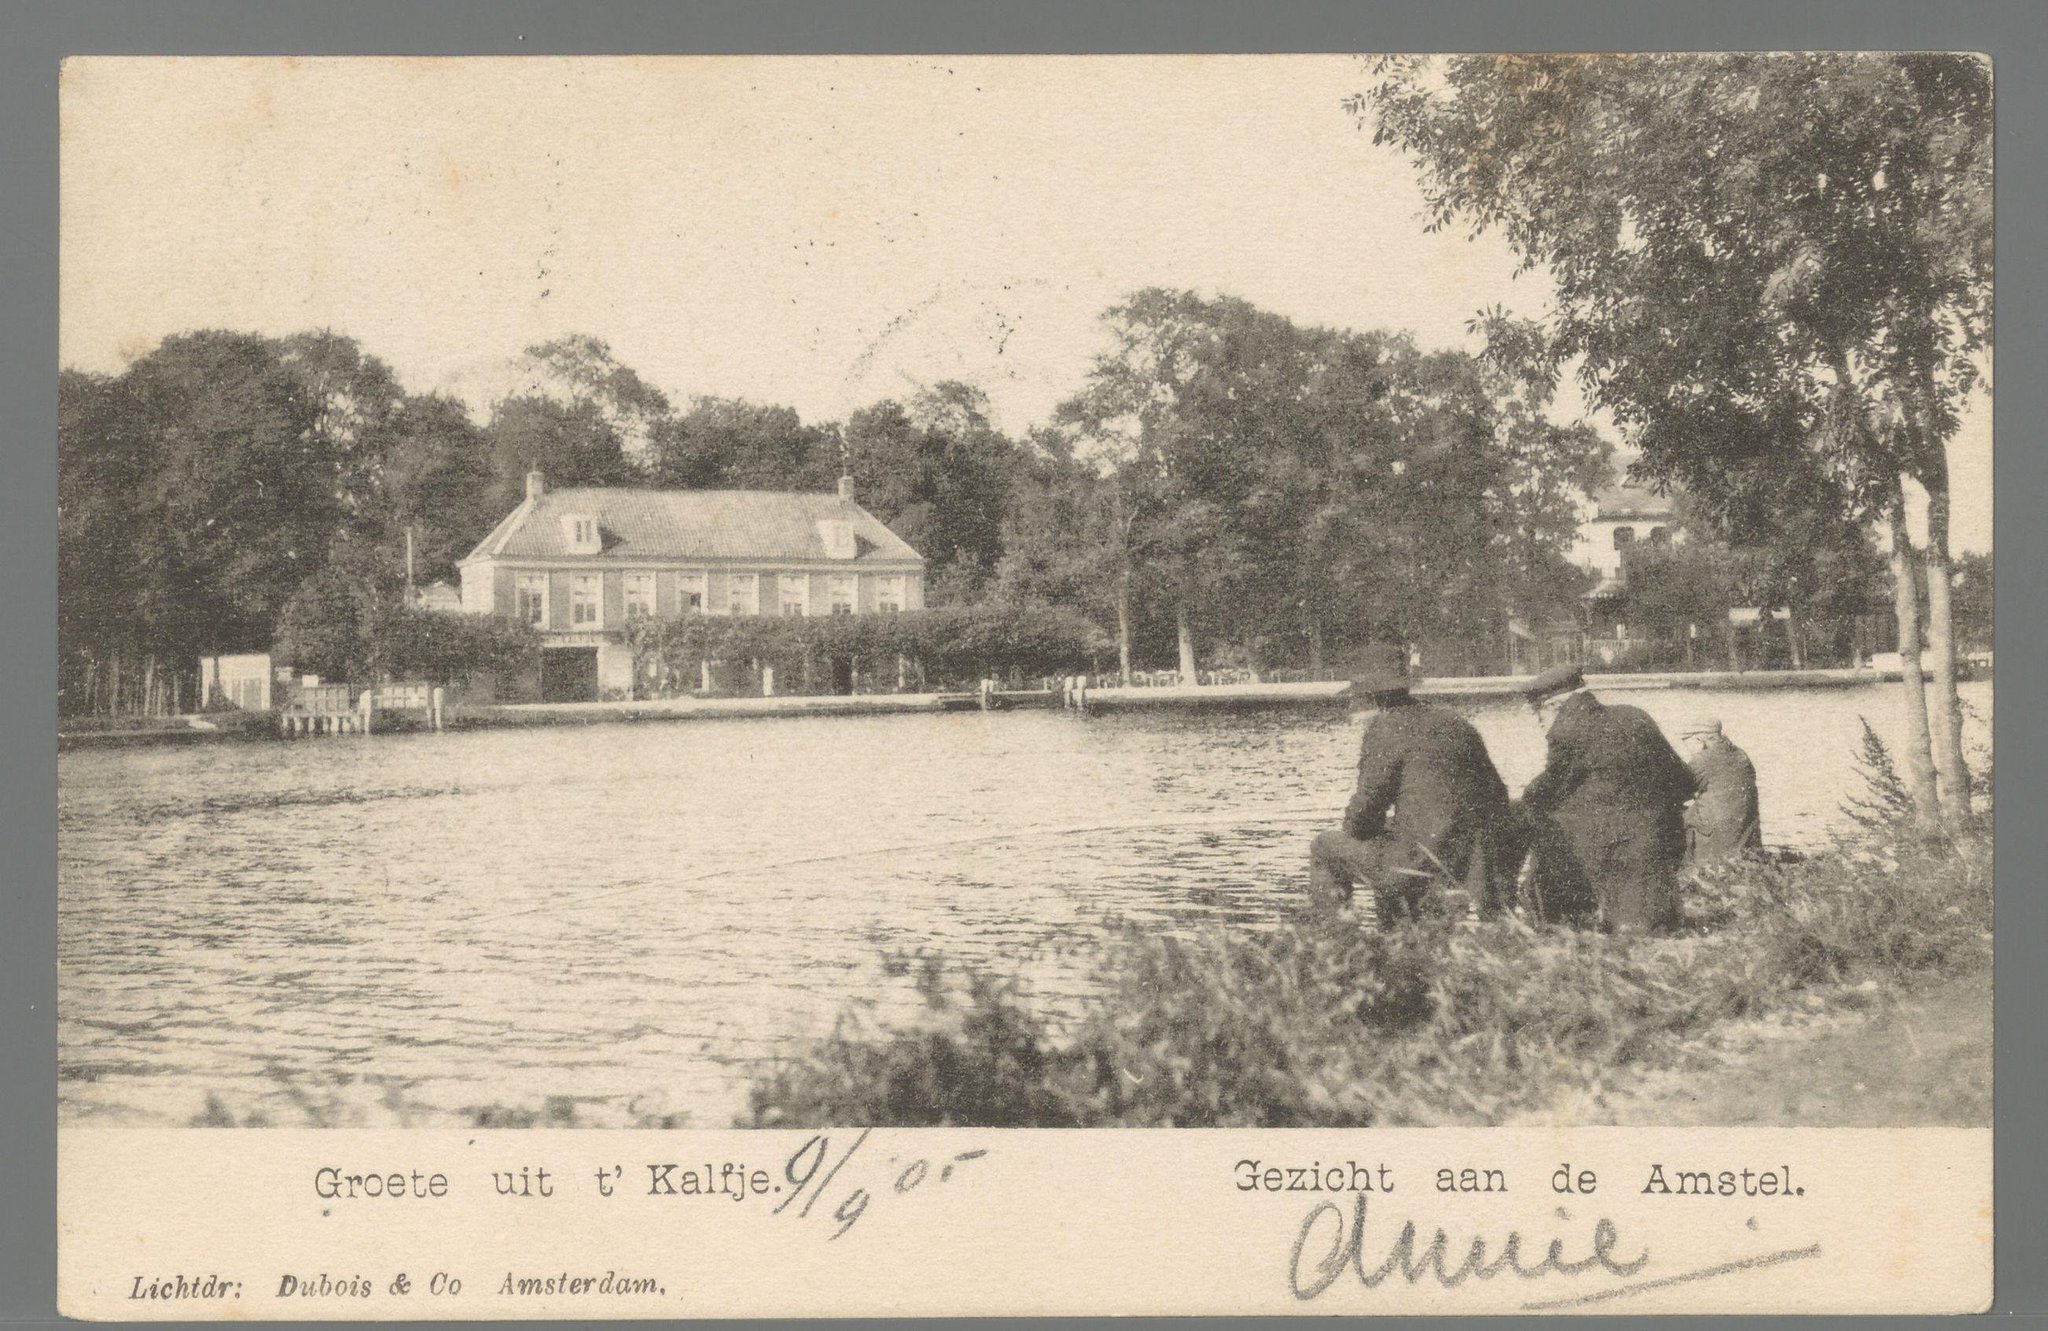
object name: photomechanical print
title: Groete uit t' Kalfje. Gezicht aan de Amstel.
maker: Anonymous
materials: cardboard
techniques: photograph, writing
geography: amsterdam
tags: river bank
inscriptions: postage stamp